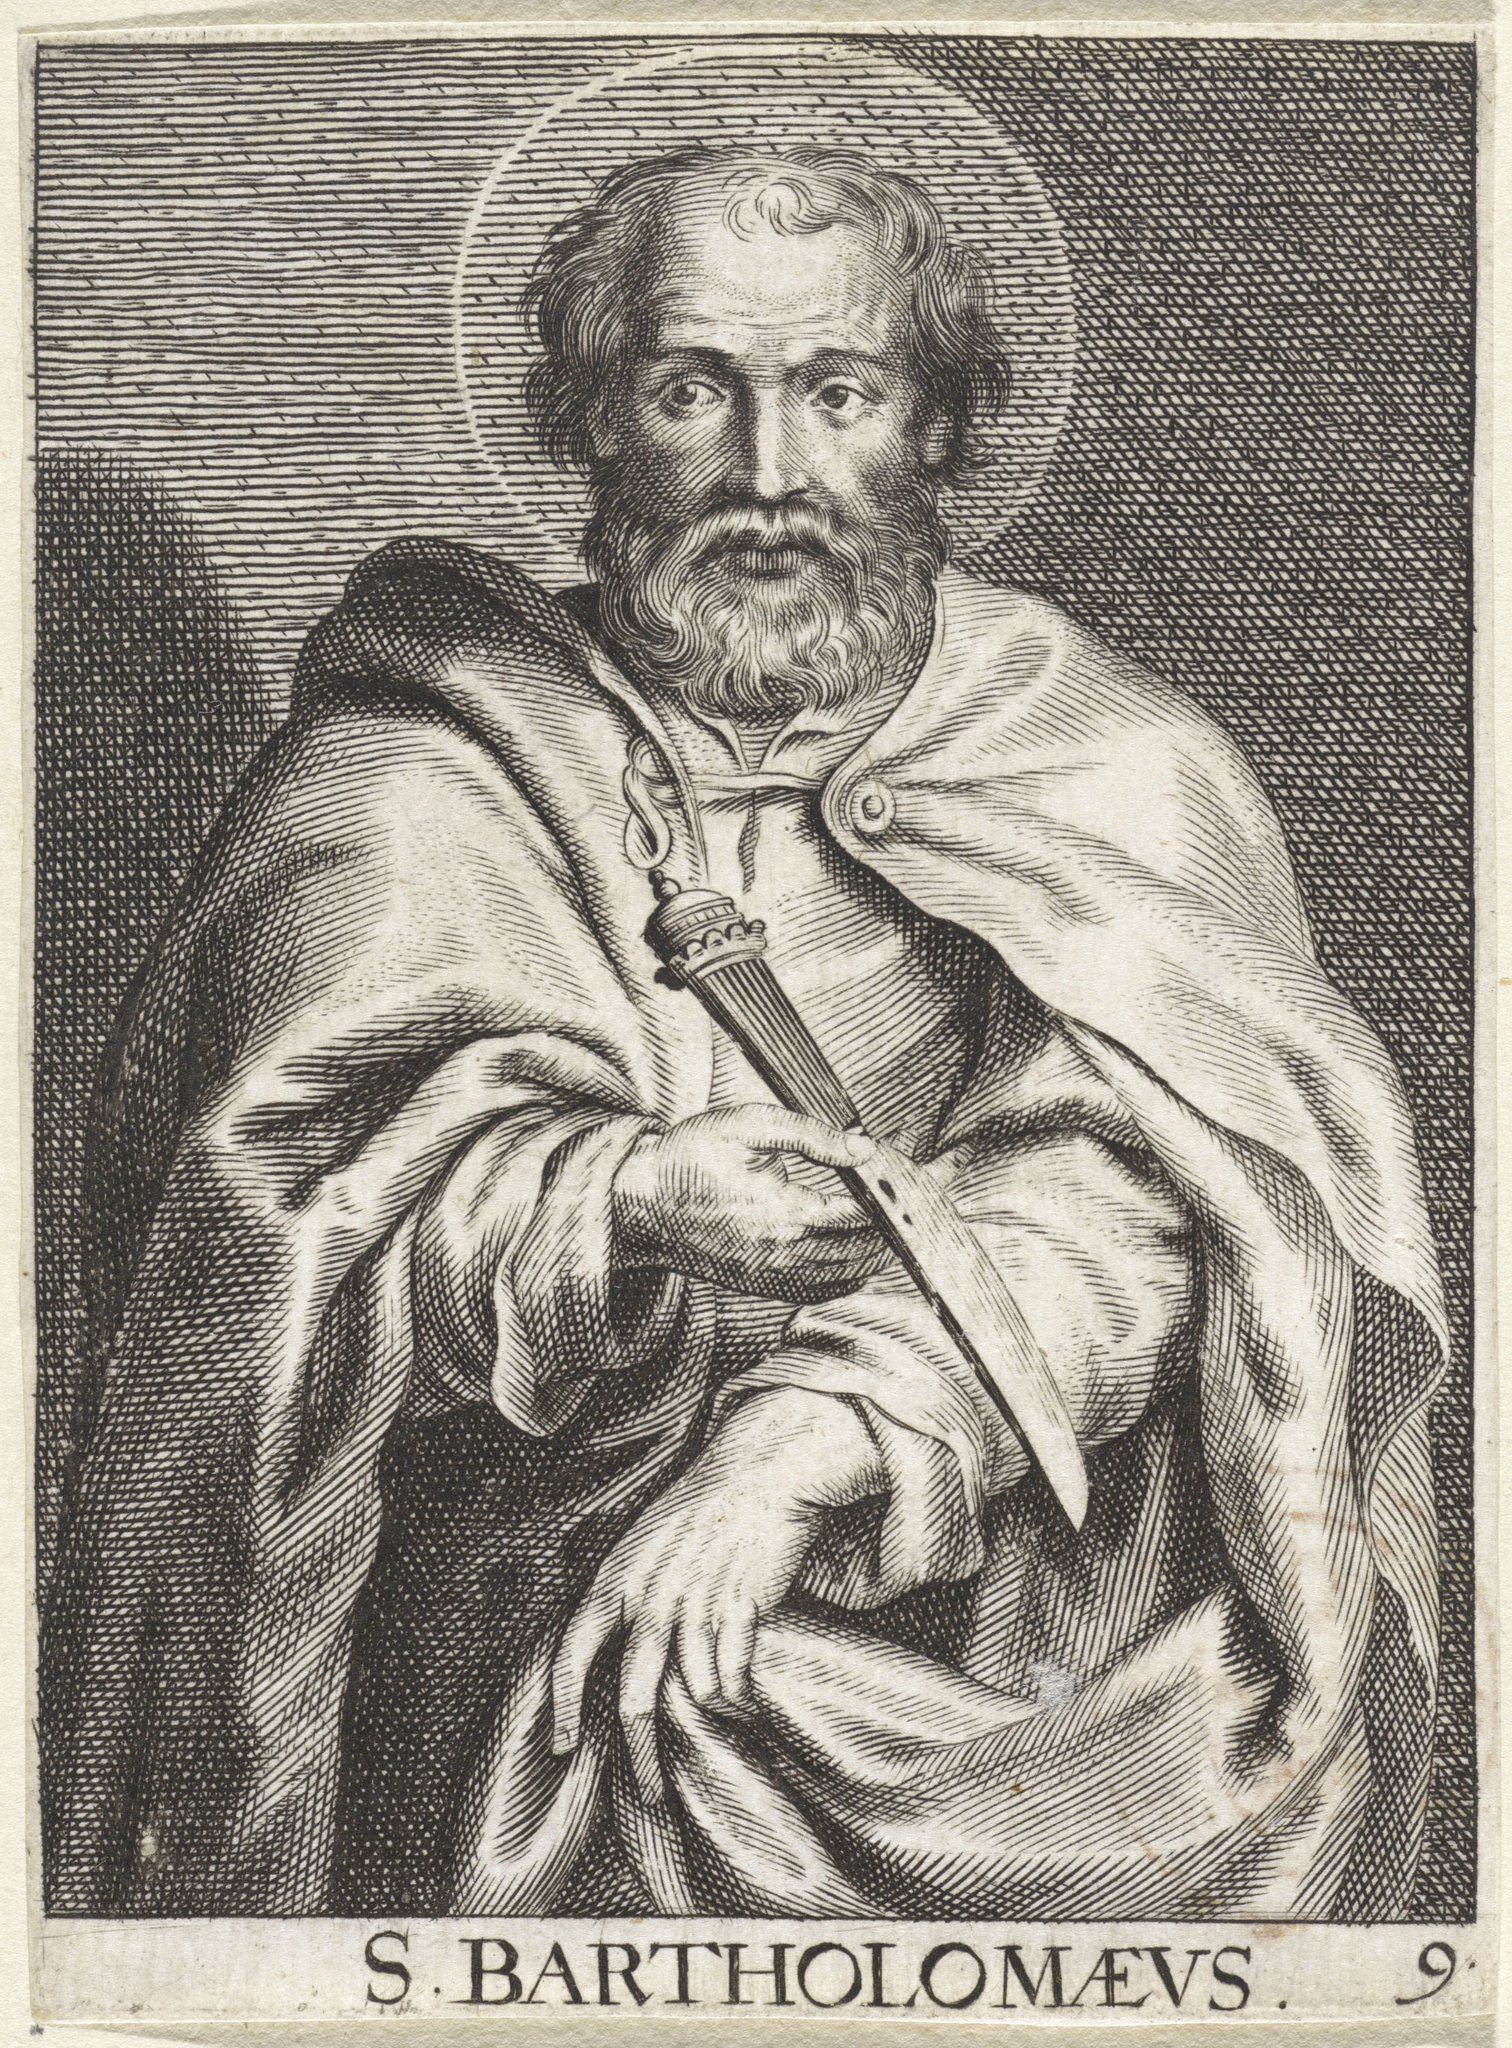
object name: print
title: S. Bartholomeus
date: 1637-1666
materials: paper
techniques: engraving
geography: southern netherlands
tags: the apostle bartholomew; possible attributes: book, devil or dragon at feet, knife, scroll, flayed skin, staff - portrait of male saint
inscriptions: collector's mark: Lugt 240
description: De apostel Bartolomeüs staat voor een muur met in zijn rechterhand het mes waarmee hij werd gevild.